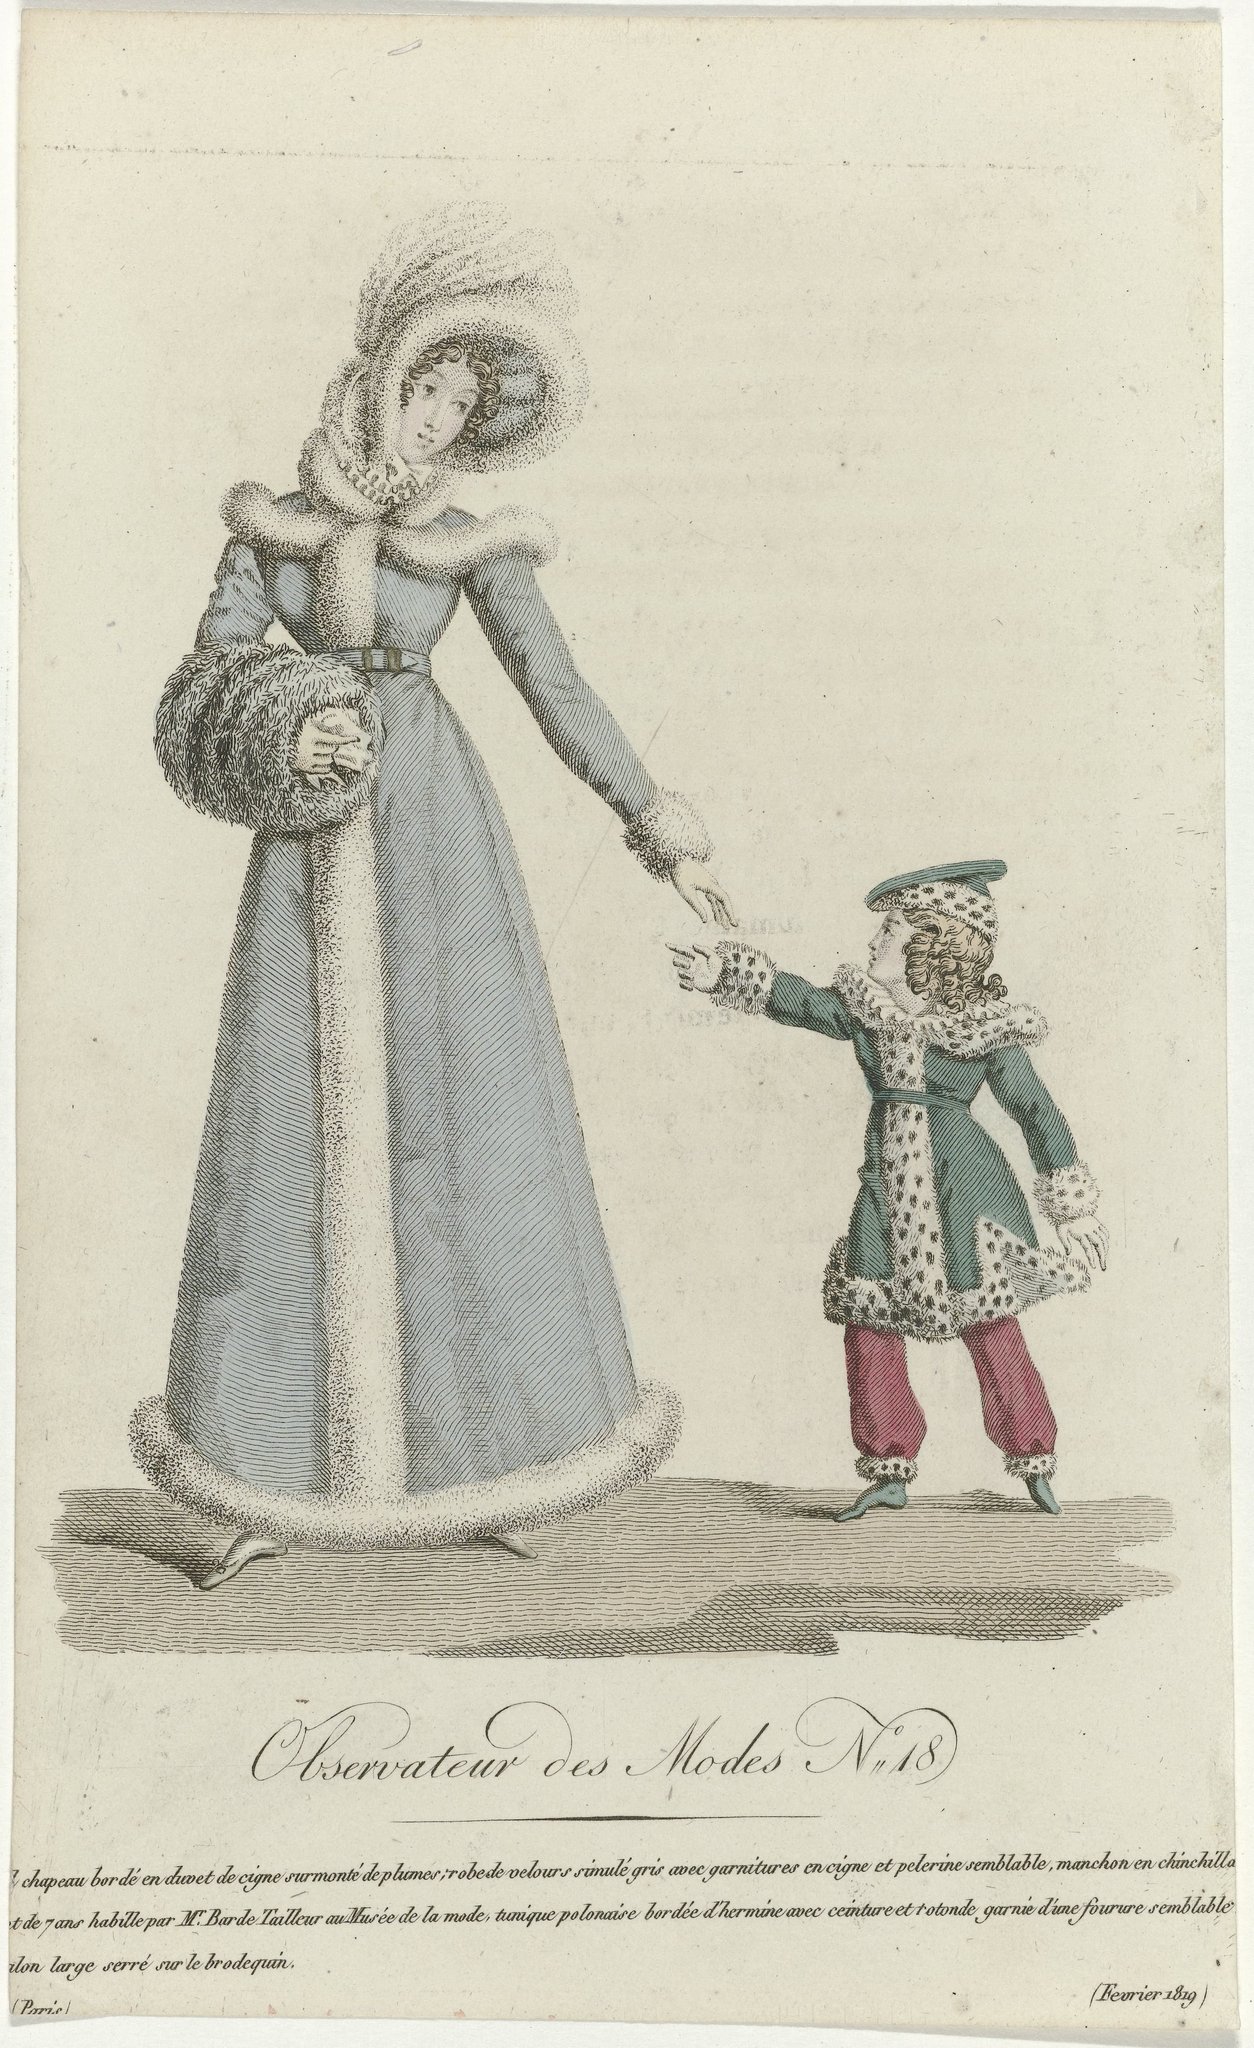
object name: fashion print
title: Observateur des Modes, fevrier 1819, No. 18: Chapeau bordé (...)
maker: Anonymous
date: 1819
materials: paper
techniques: engraving, hand coloring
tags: clothing for the upper part of the body (pelerine) (+ women's clothes), border, ribbon, braid (+ feathers used for clothes), head-gear (+ girls' clothes), belt, girdle, waistband (+ girls' clothes), boots (+ girls' clothes), clothing for the upper part of the body (tunic) (+ girls' clothes), trousers, breeches (+ girls' clothes), fashion plates, head-gear: hat (+ women's clothes), shoes, sandals (+ women's clothes), dress, gown (+ women's clothes), muff (+ fur used for clothes)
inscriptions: caption: ‘...chapeau bordé en duvet de cigne surmonté de plumes; robe de velours simulé gris avec garnitures en cigne et pelerine semblable, manchon en chinchilla... (ontbreekt).. de 7 ans habille par M.r Barde Tailleur au musée de la mode, tunique polonaise bordée d'hermine avec ceinture et rotonde garnie d'une fourure semblable..(pant)alon large serré sur le brodequin.’, title: ‘Observateur des Modes No"18’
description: Hoed afgezet met zwanendons en met bovenop veren. Japon en pelerine van 'velours simulé gris' afgezet met zwanendons. Mof van chinchilla. Kinderkleding voor een kind van zeven jaar oud door Mr Barde, kleermaker of 'Tailleur au musée de la mode'. 'Tunique polonaise', afgezet met hermelijn. Ceintuur en 'rotonde', ook afgezet met hermelijn. Lange ruime broek, nauwsluitend op de laarzen. Prent uit het modetijdschrift Observateur des Modes (août 1818 - 30 novembre 1823).